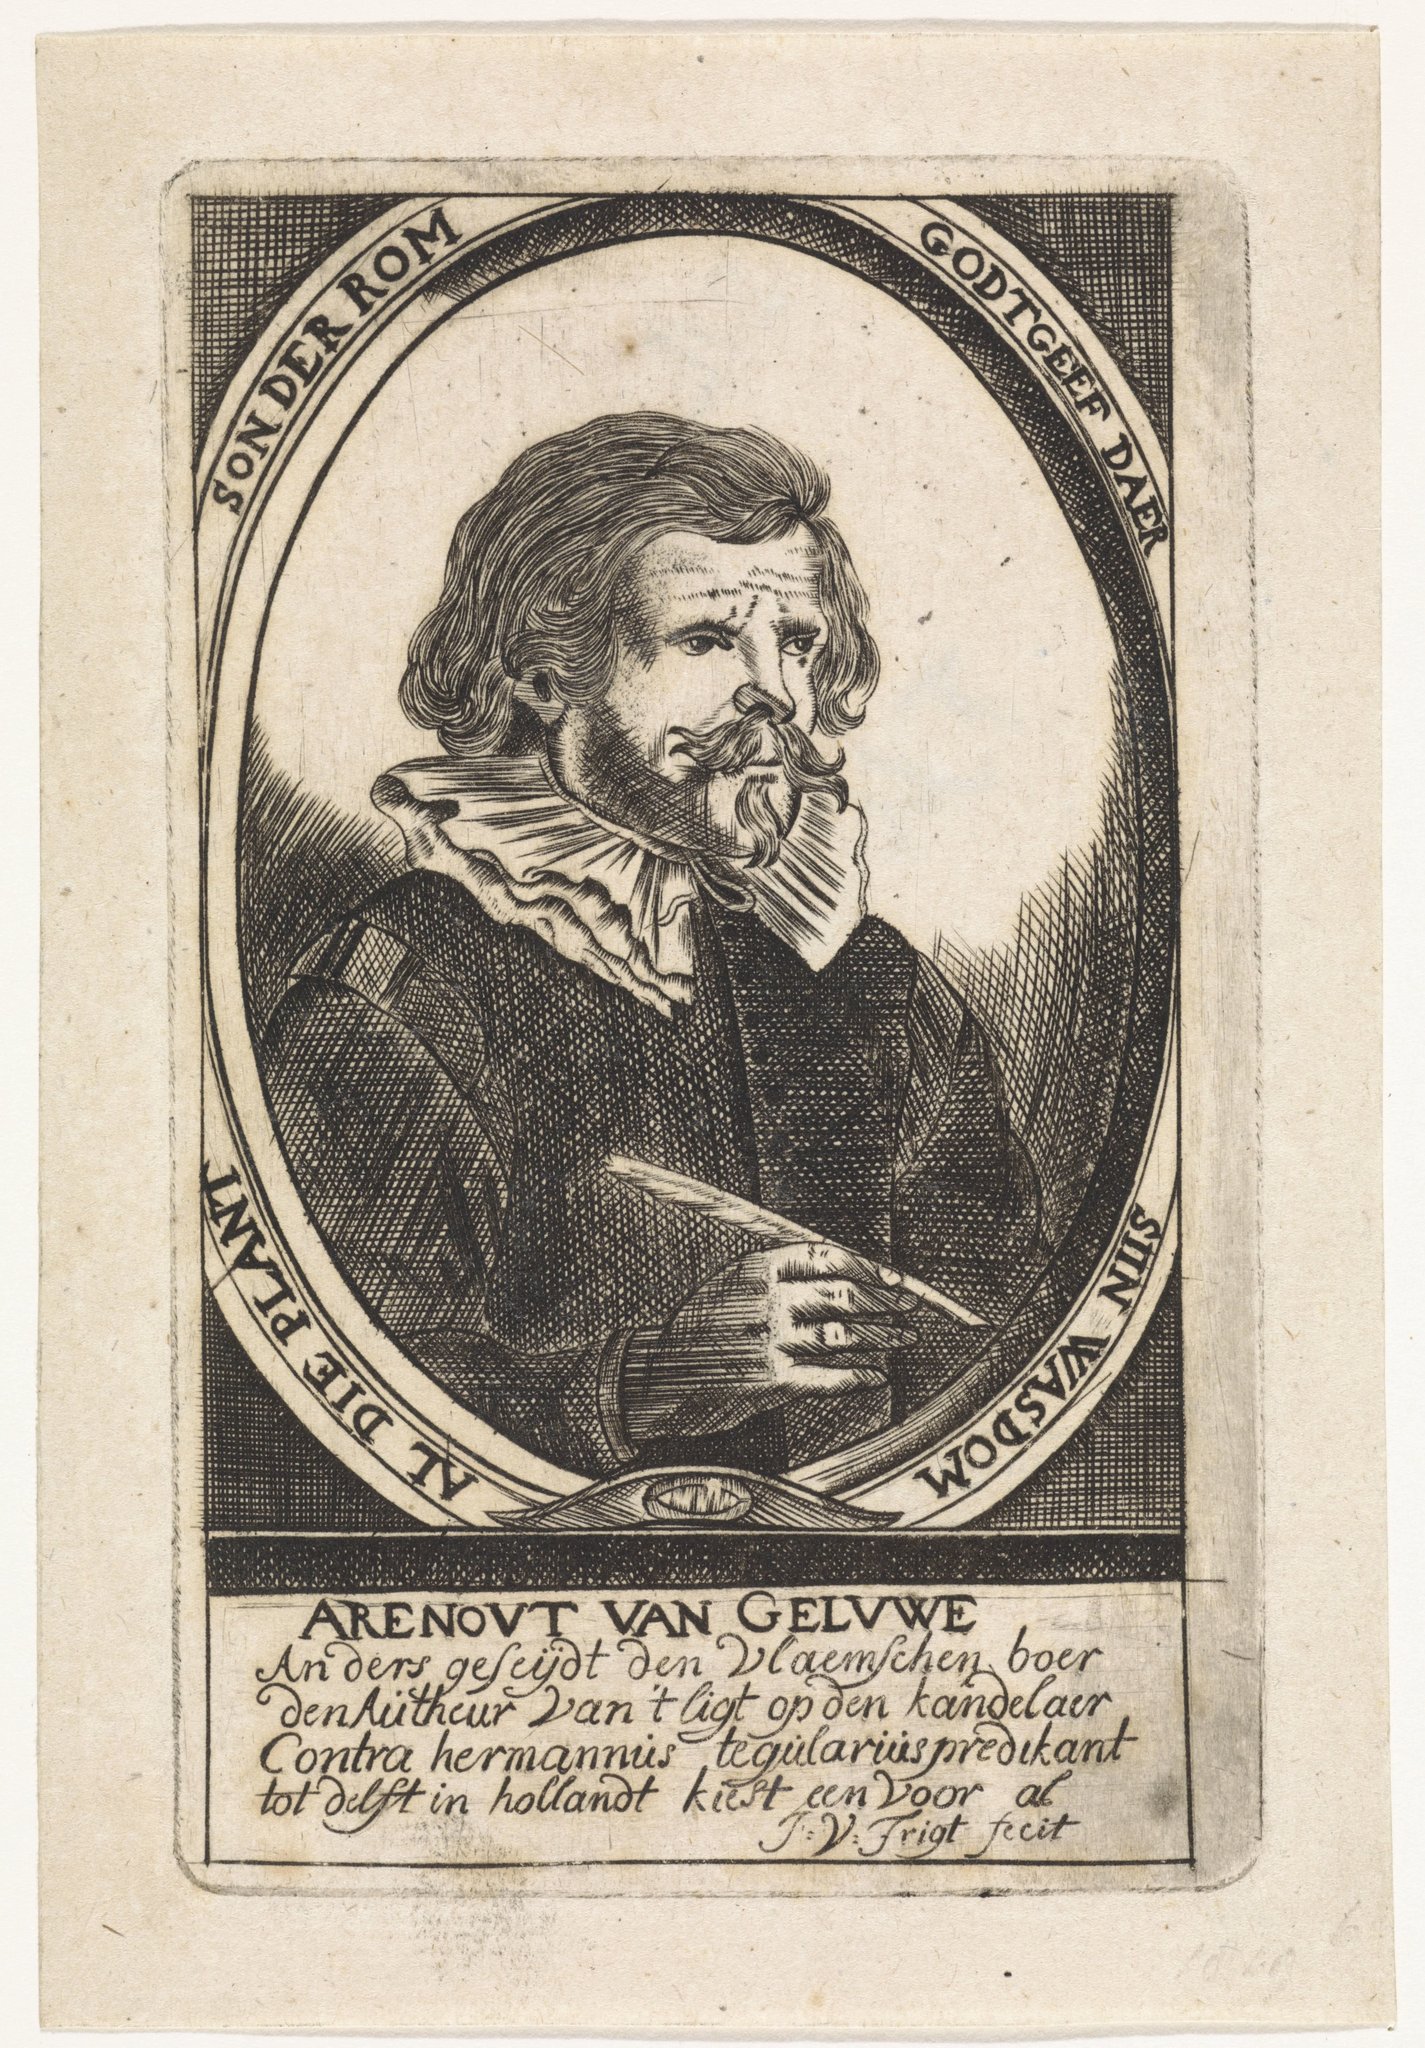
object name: print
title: Portret van Aernout van Geluwe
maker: j. van trigt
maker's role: print maker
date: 1640-1660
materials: paper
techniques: etching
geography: netherlands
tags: quill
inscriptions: collector's mark: Lugt 2228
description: Portret van Rooms-Katholiek dichter Aernout van Geluwe. Zijn pseudoniem was: Vlaemschen Boer.